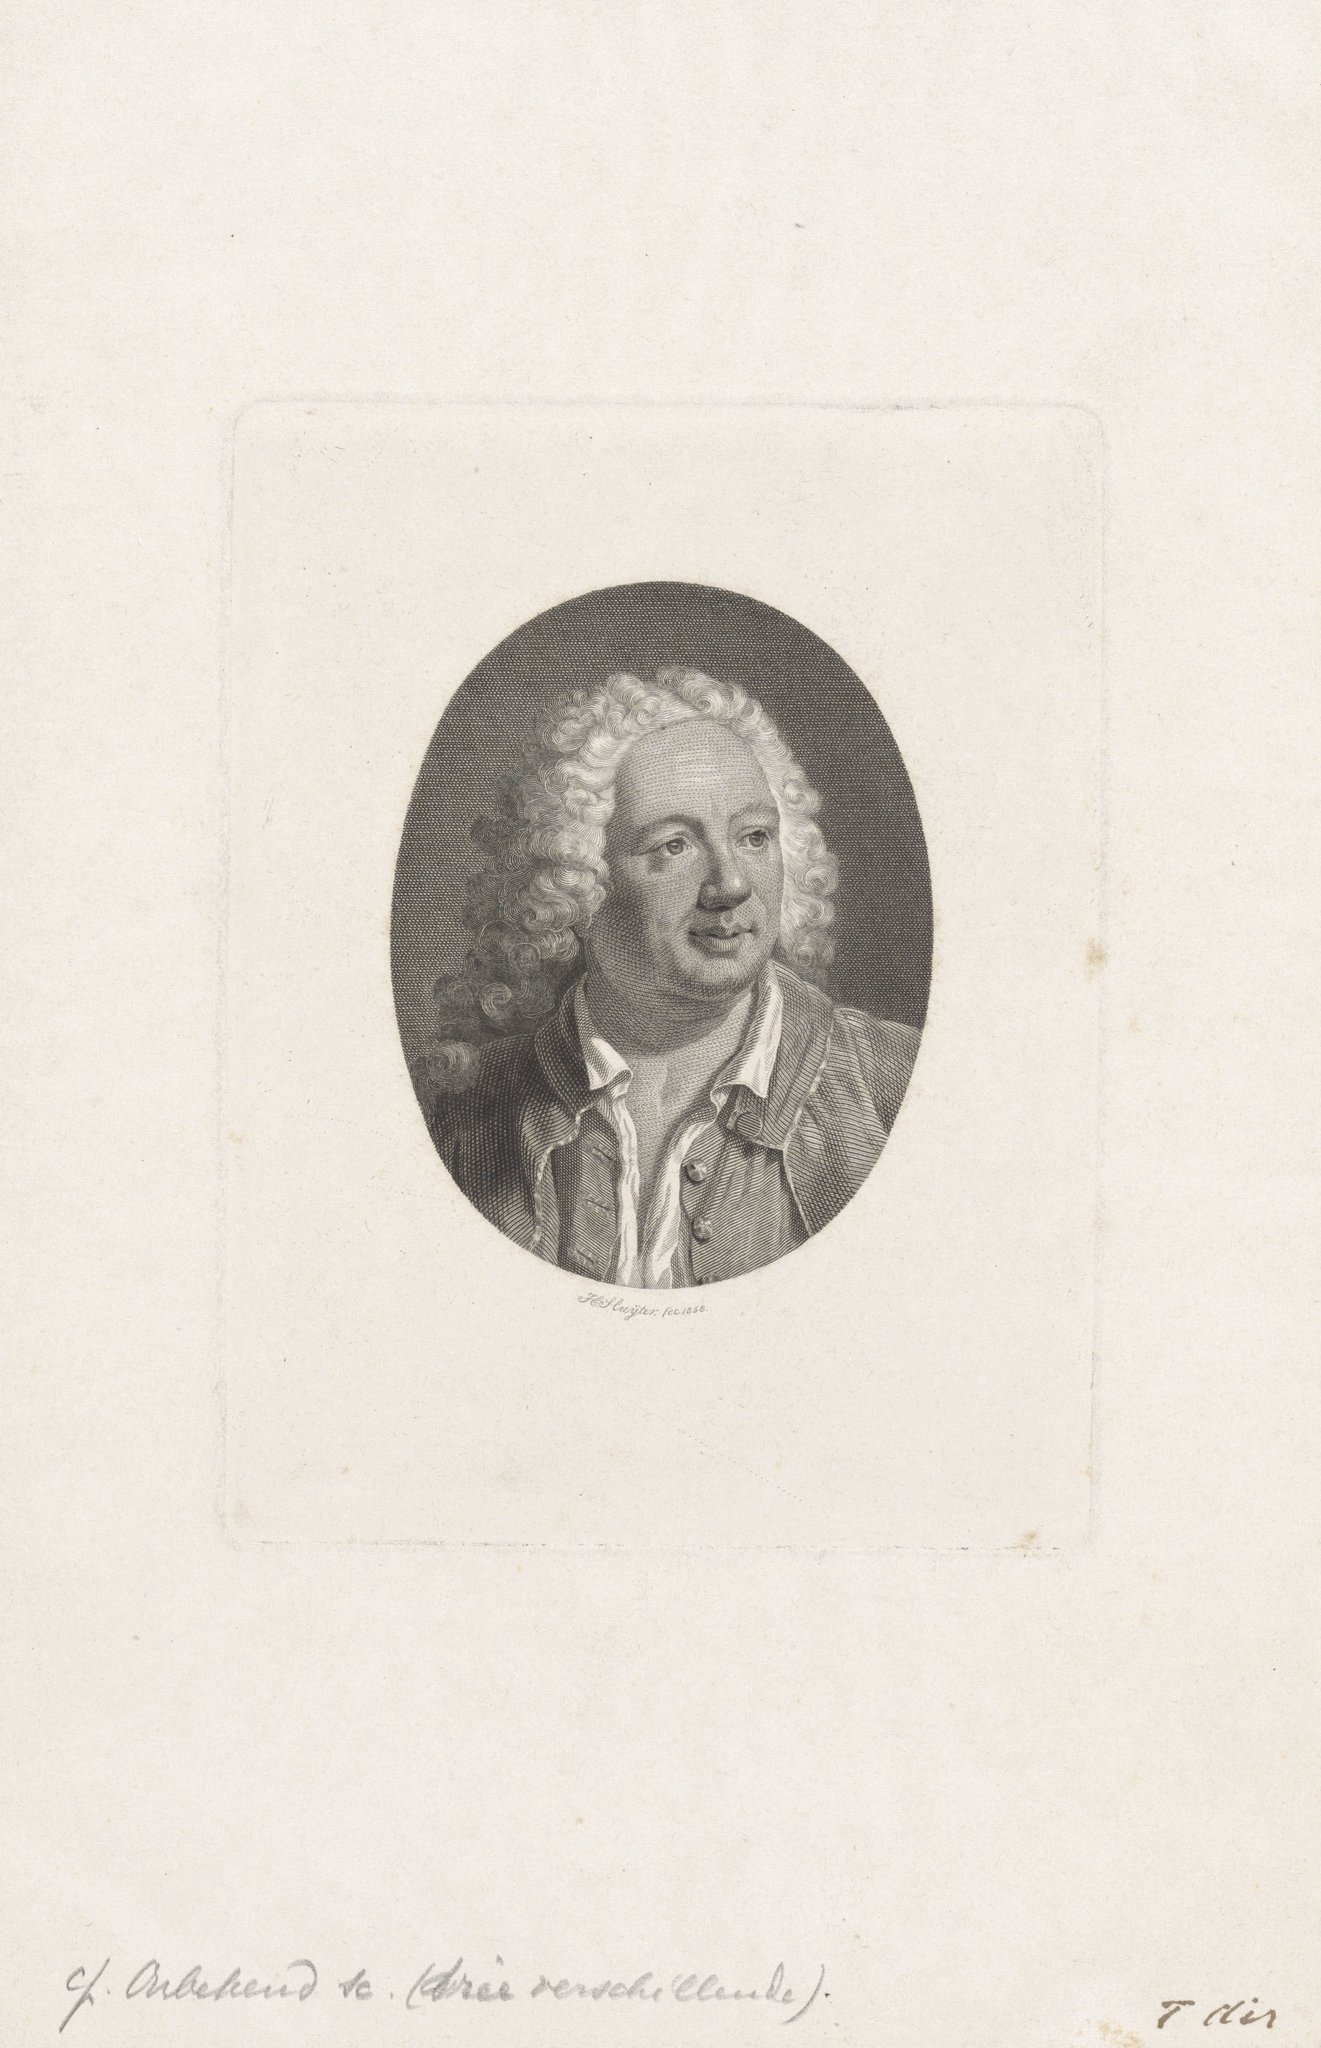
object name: print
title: Portret van Jean Baptiste Rousseau (1671-1741)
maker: hendrik d. jzn sluyter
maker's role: print maker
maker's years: 1839-1931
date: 1858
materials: paper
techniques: engraving, etching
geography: amsterdam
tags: paris, brussels, jean baptiste rousseau (1669-1741)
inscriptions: collector's mark: Lugt 2228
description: Portret van de Franse schrijver en componist Jean Baptiste Rousseau (1671-1741), met nonchalant open hangend hemd.